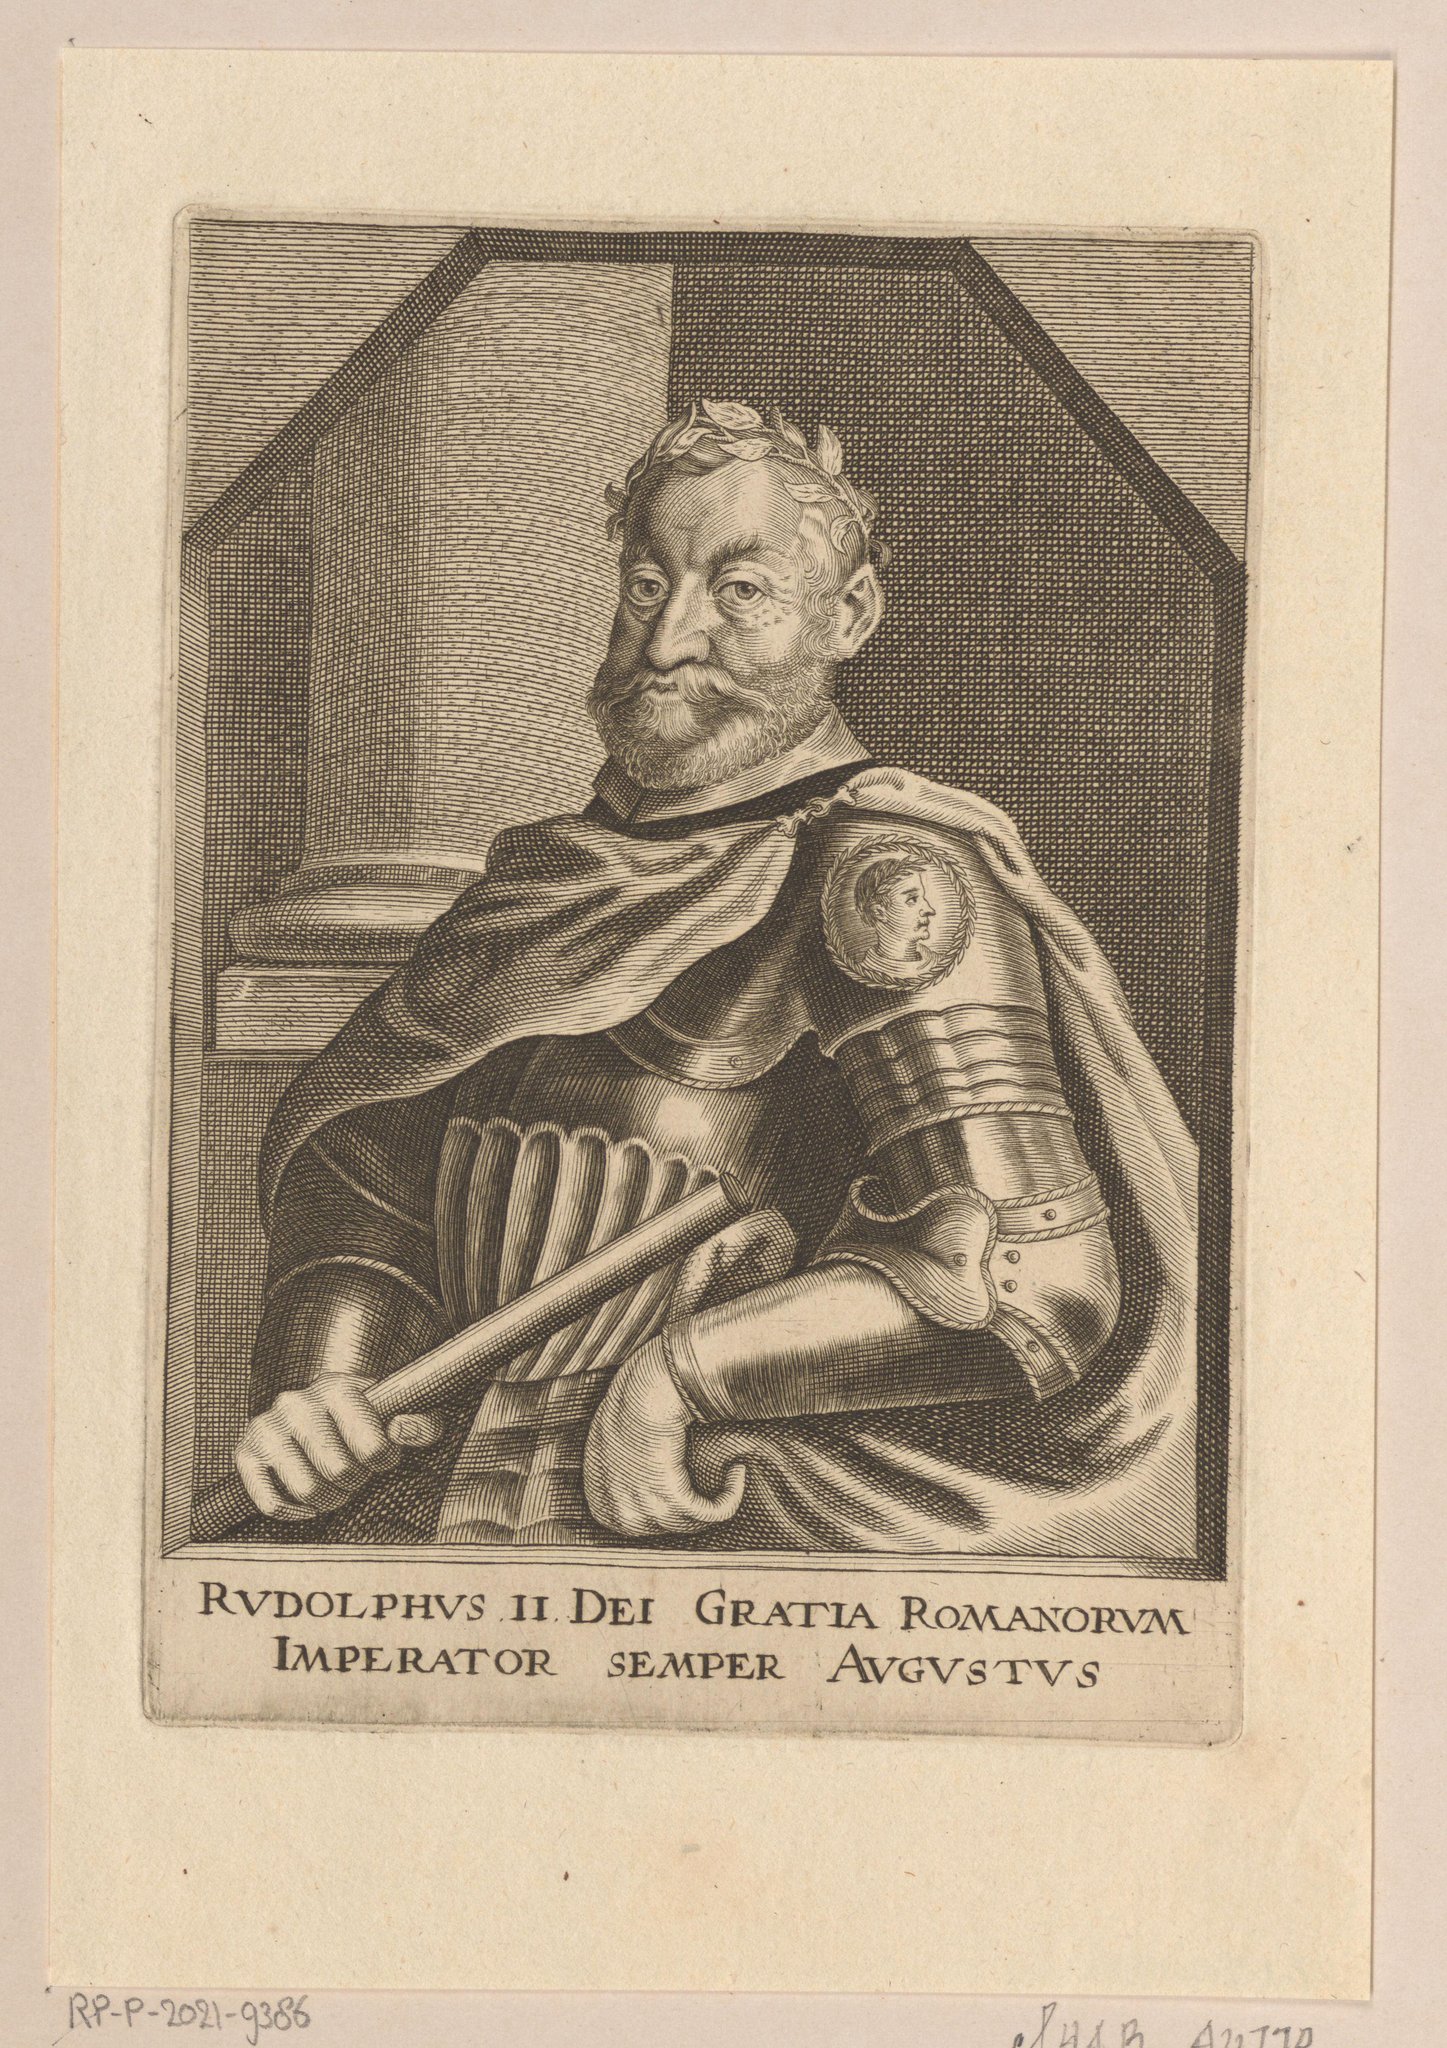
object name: print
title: Portret van Rudolf II van Habsburg, Duits keizer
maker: Anonymous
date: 1650-1749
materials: paper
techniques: engraving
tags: vienna, prague, rudolf ii van habsburg (duits keizer), historical persons, armorial bearing, heraldry